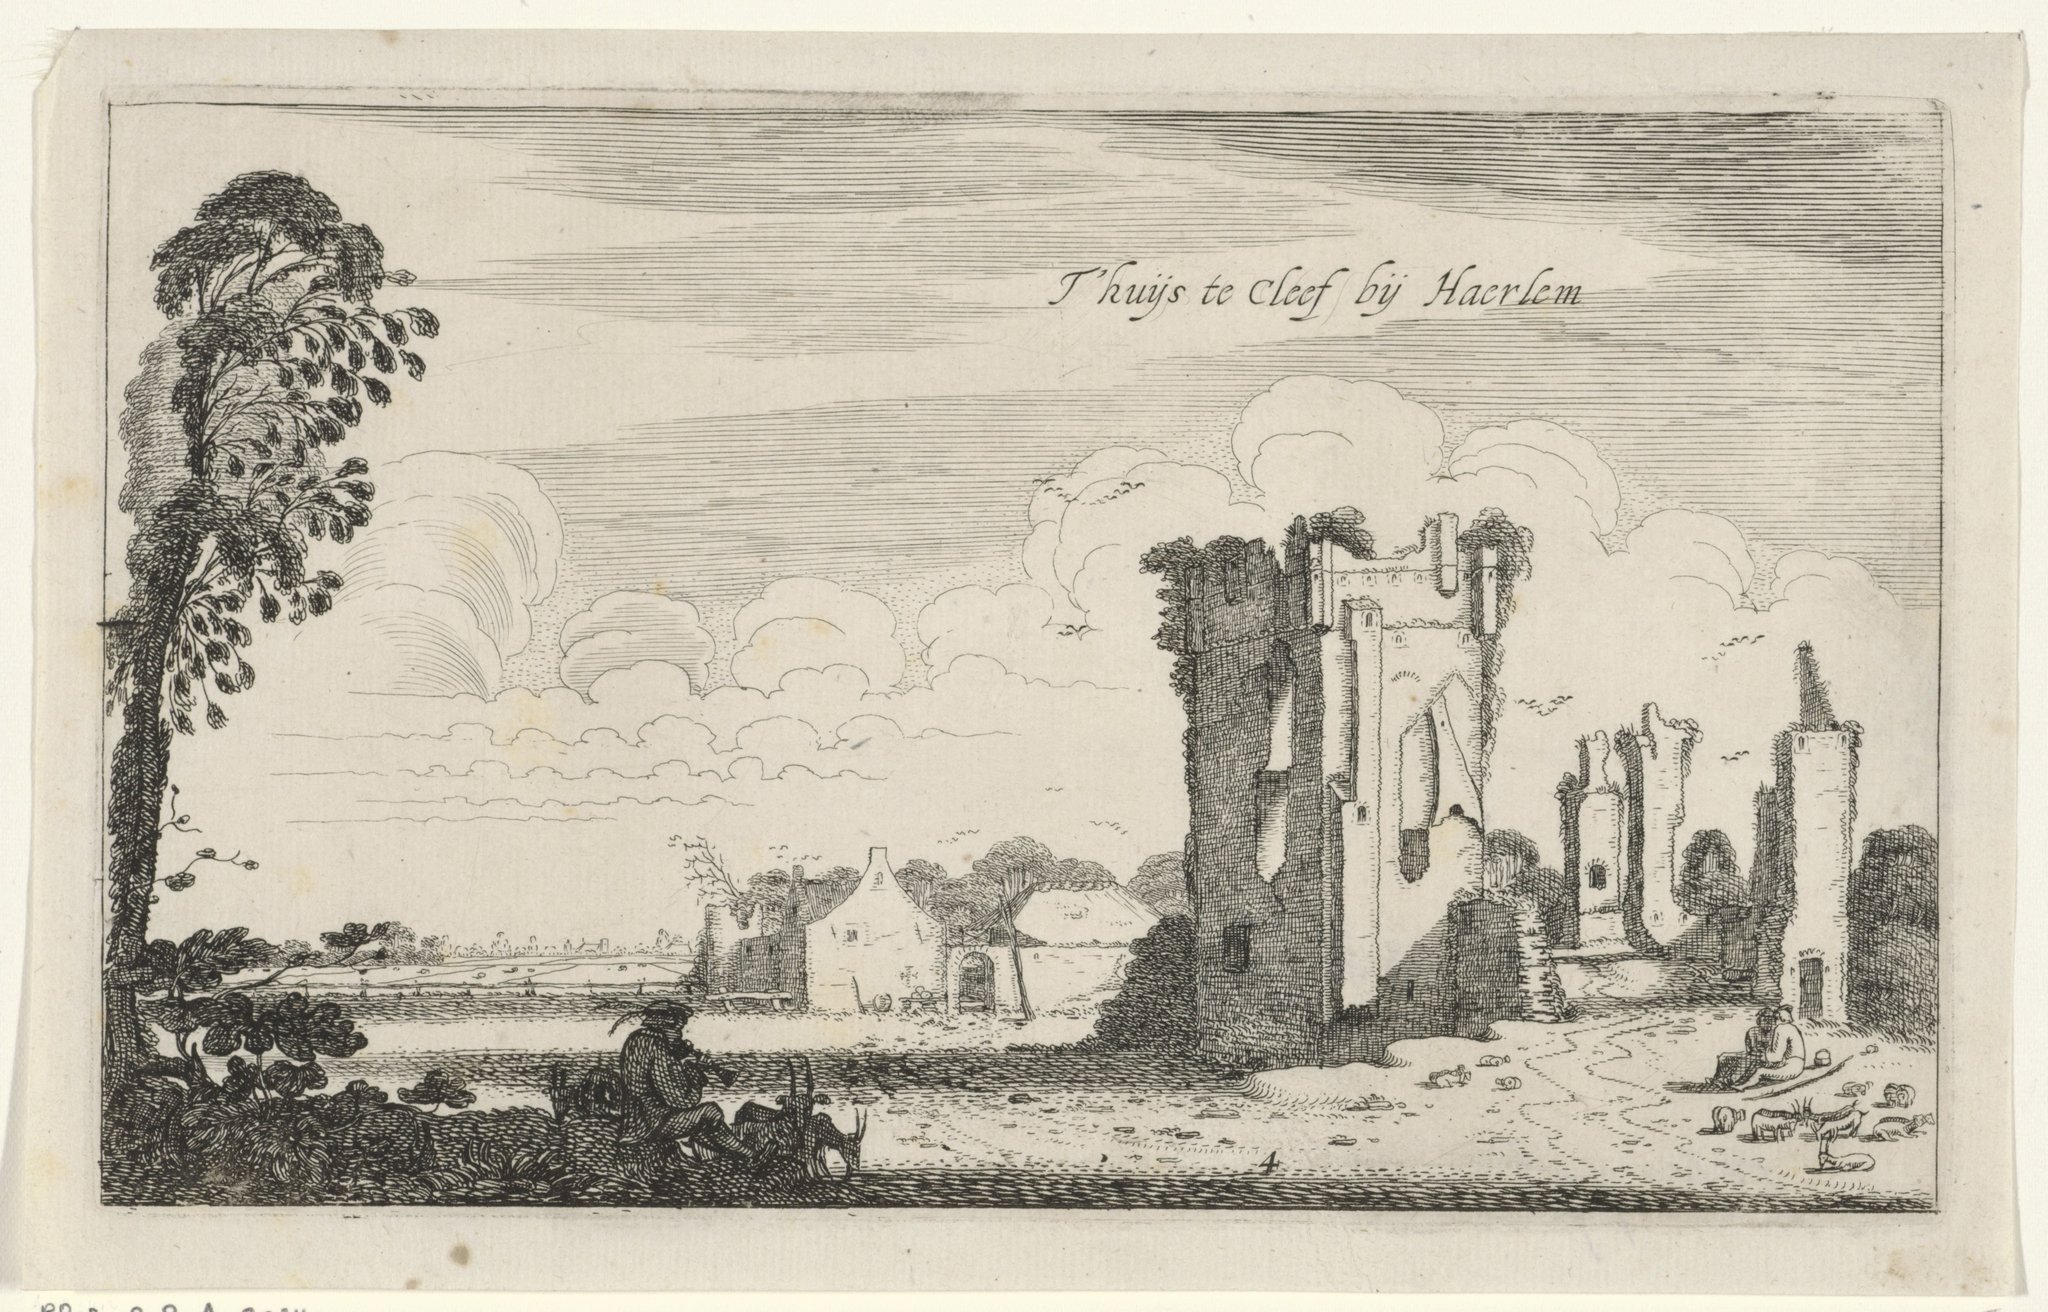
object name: print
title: Gezicht op de ruïne van Huis ter Kleef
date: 1616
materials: paper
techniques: etching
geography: northern netherlands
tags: landscape with ruins, landscape with tower or castle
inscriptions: collector's mark: Lugt 964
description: Ruïne van het Huis ter Kleef, op de voorgrond links een herder met bokken. Rechts twee converserende figuren. Vierde prent uit een serie van zes.